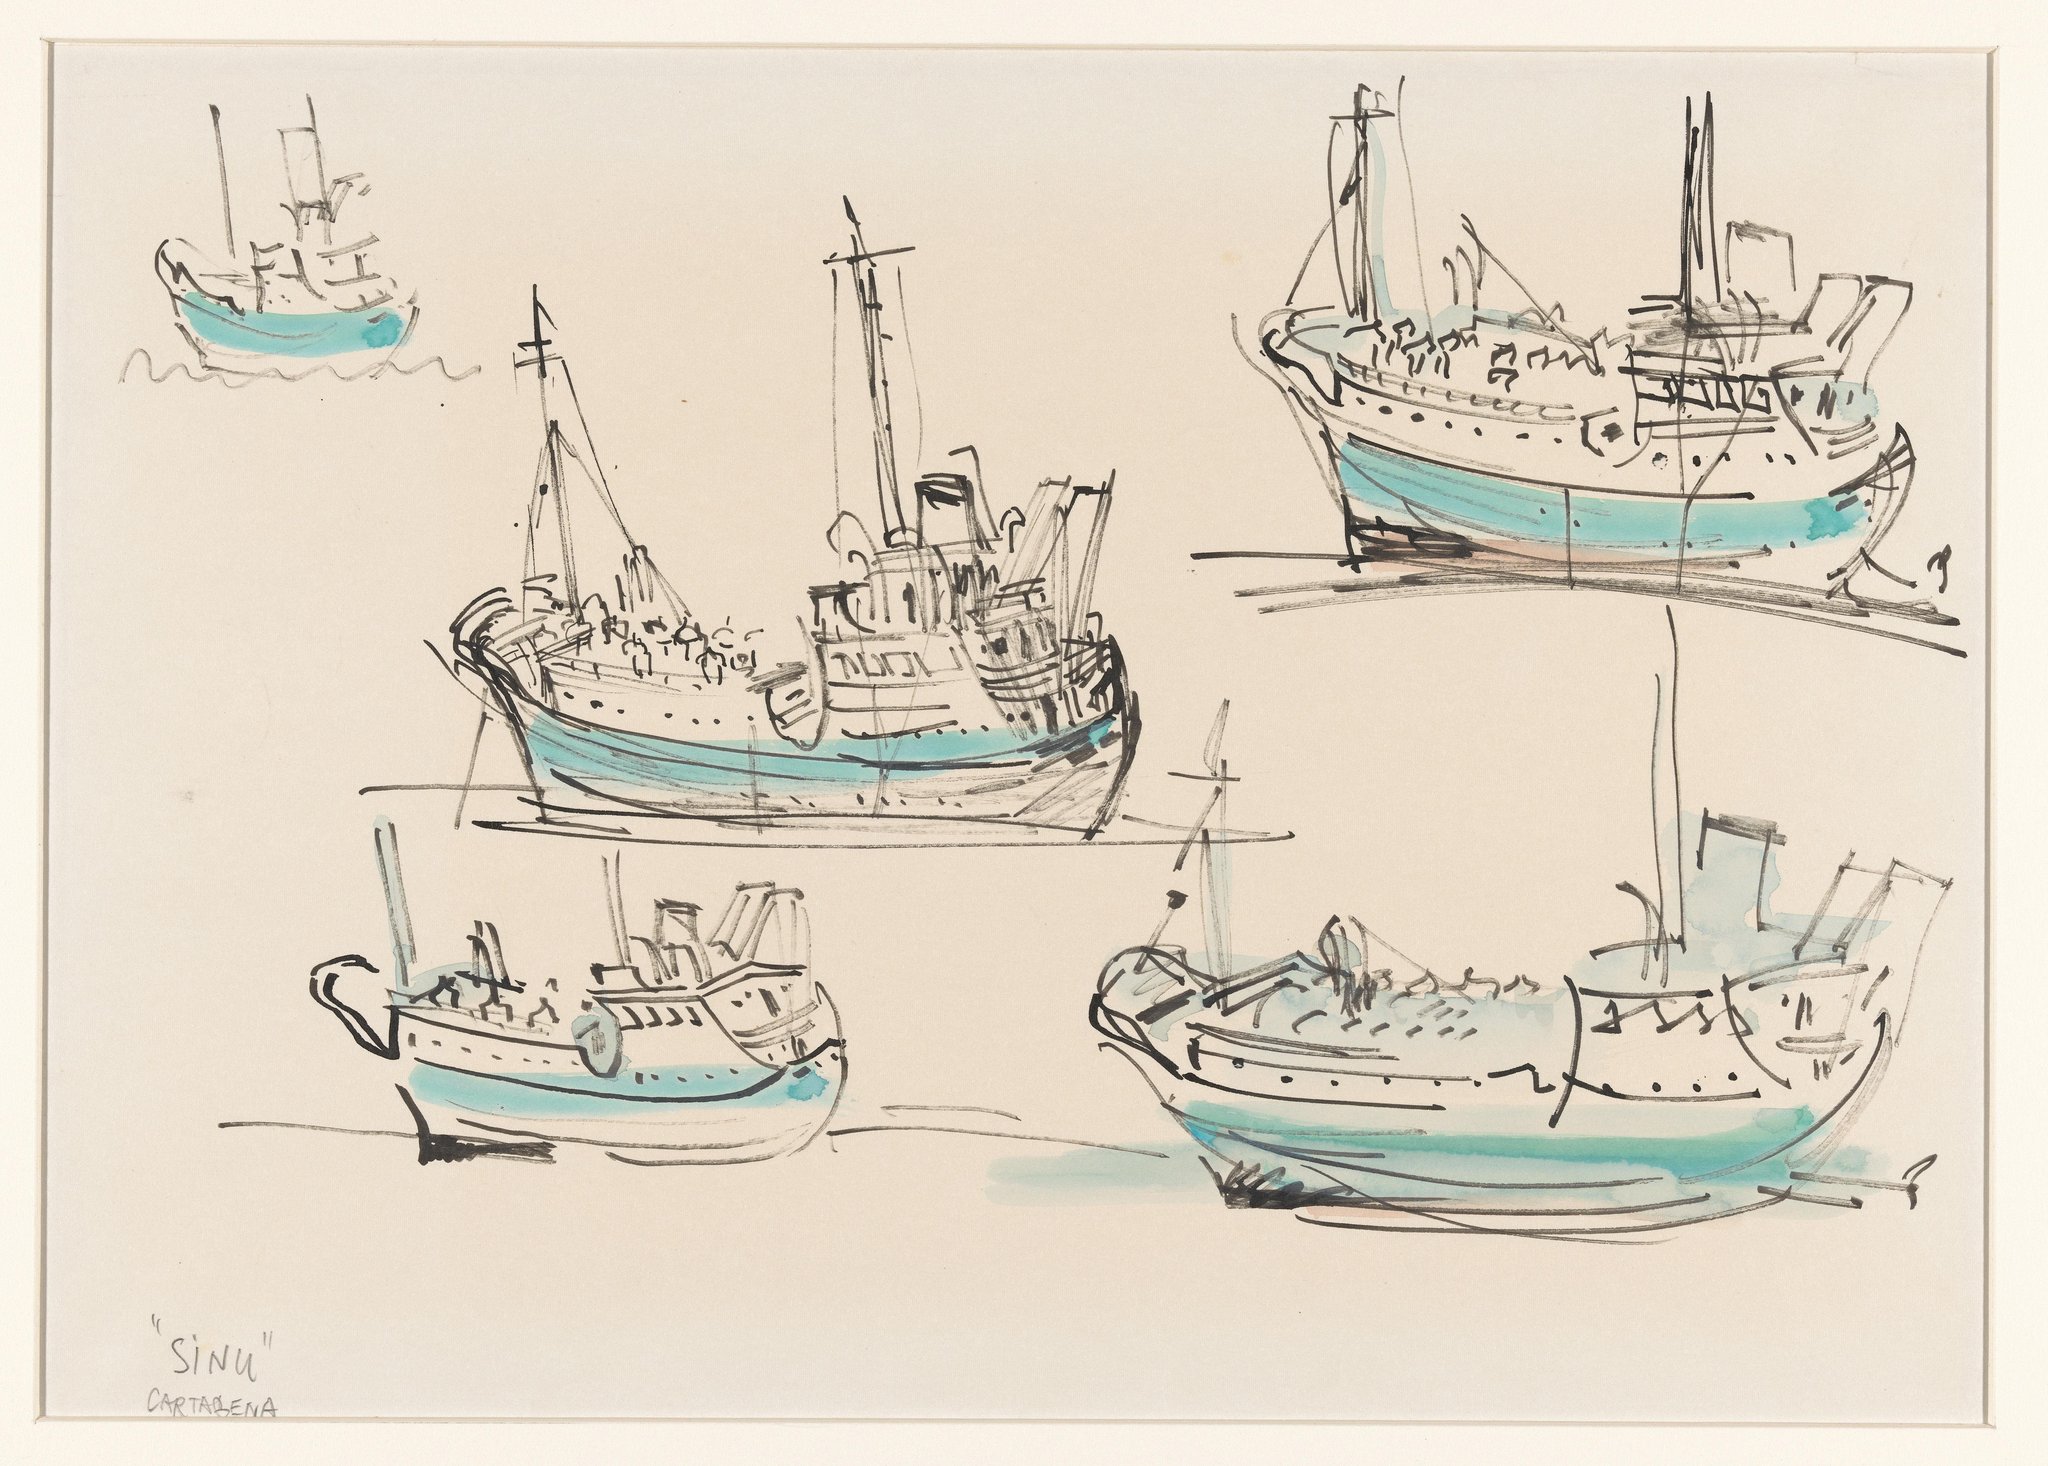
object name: drawing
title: "Sinu" Cartagena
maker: q. halbertsma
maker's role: draughtsman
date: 1940-1958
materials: ink, paper, watercolor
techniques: brush, pen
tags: names of artefacts and man-made objects (buildings excluded), steamship, motorship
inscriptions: collector's mark: Lugt 2228